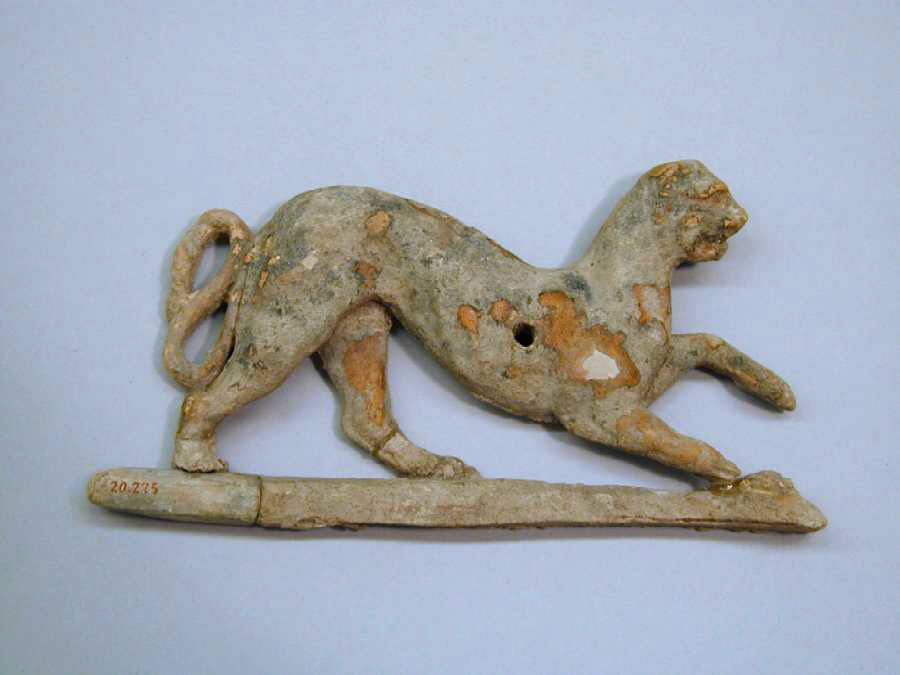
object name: relief of a panther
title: Terracotta appliqué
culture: greek, south italian, tarentine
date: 300-201 BCE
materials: terracotta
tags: animals